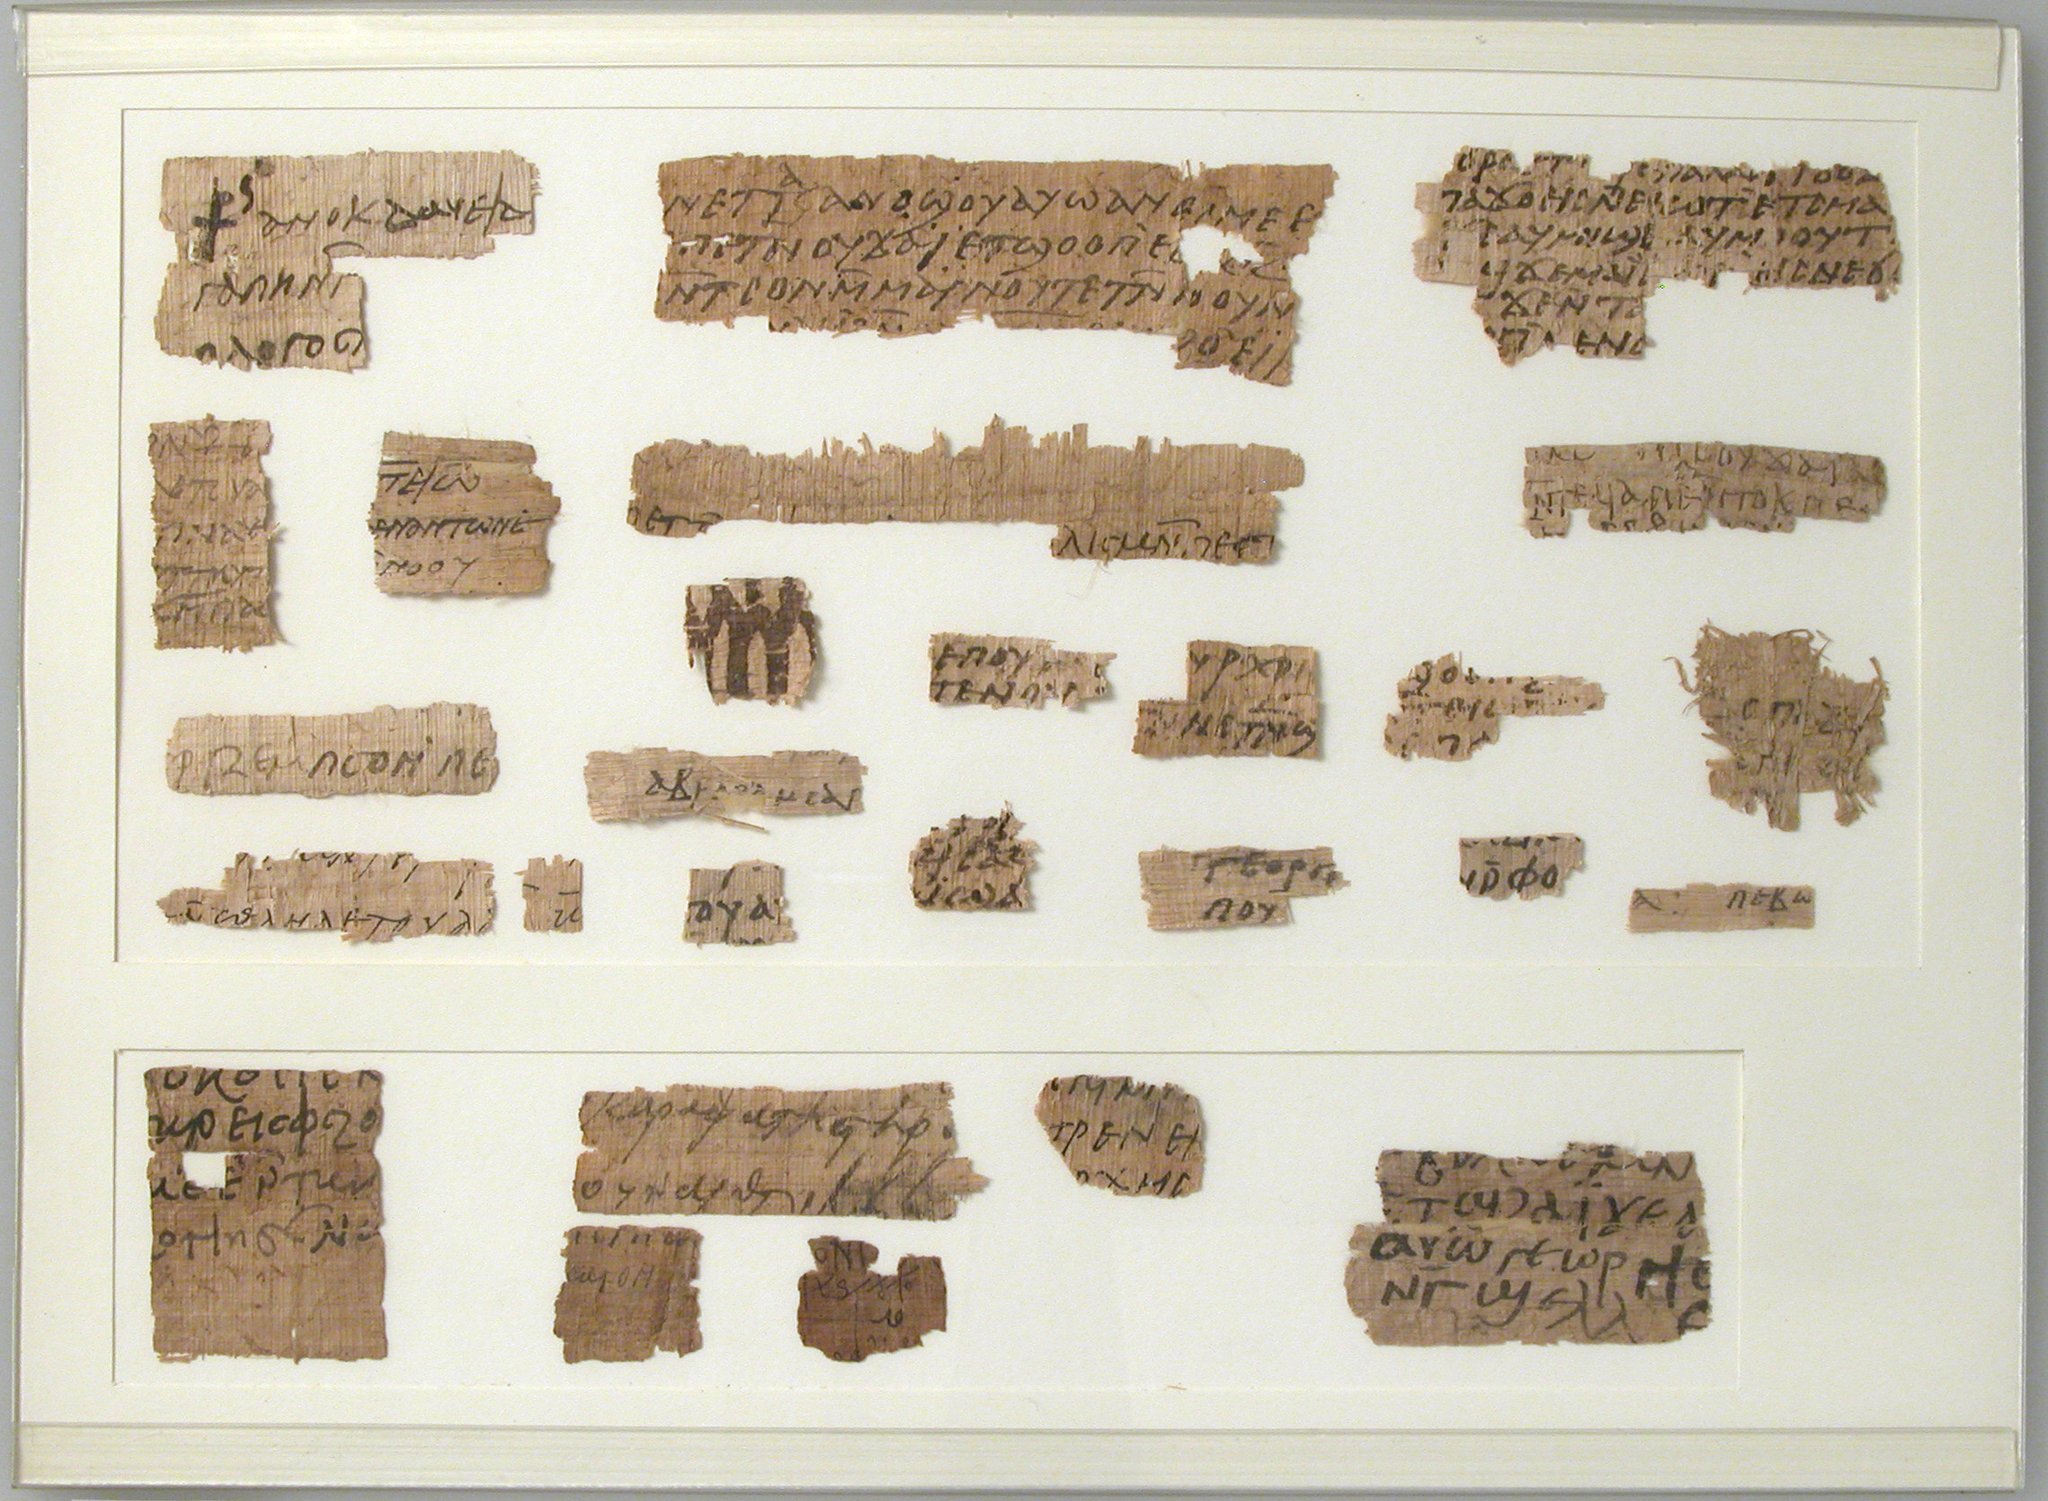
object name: fragment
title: Papyri Fragments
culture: coptic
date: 601-700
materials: ink, papyrus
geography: egypt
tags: documents